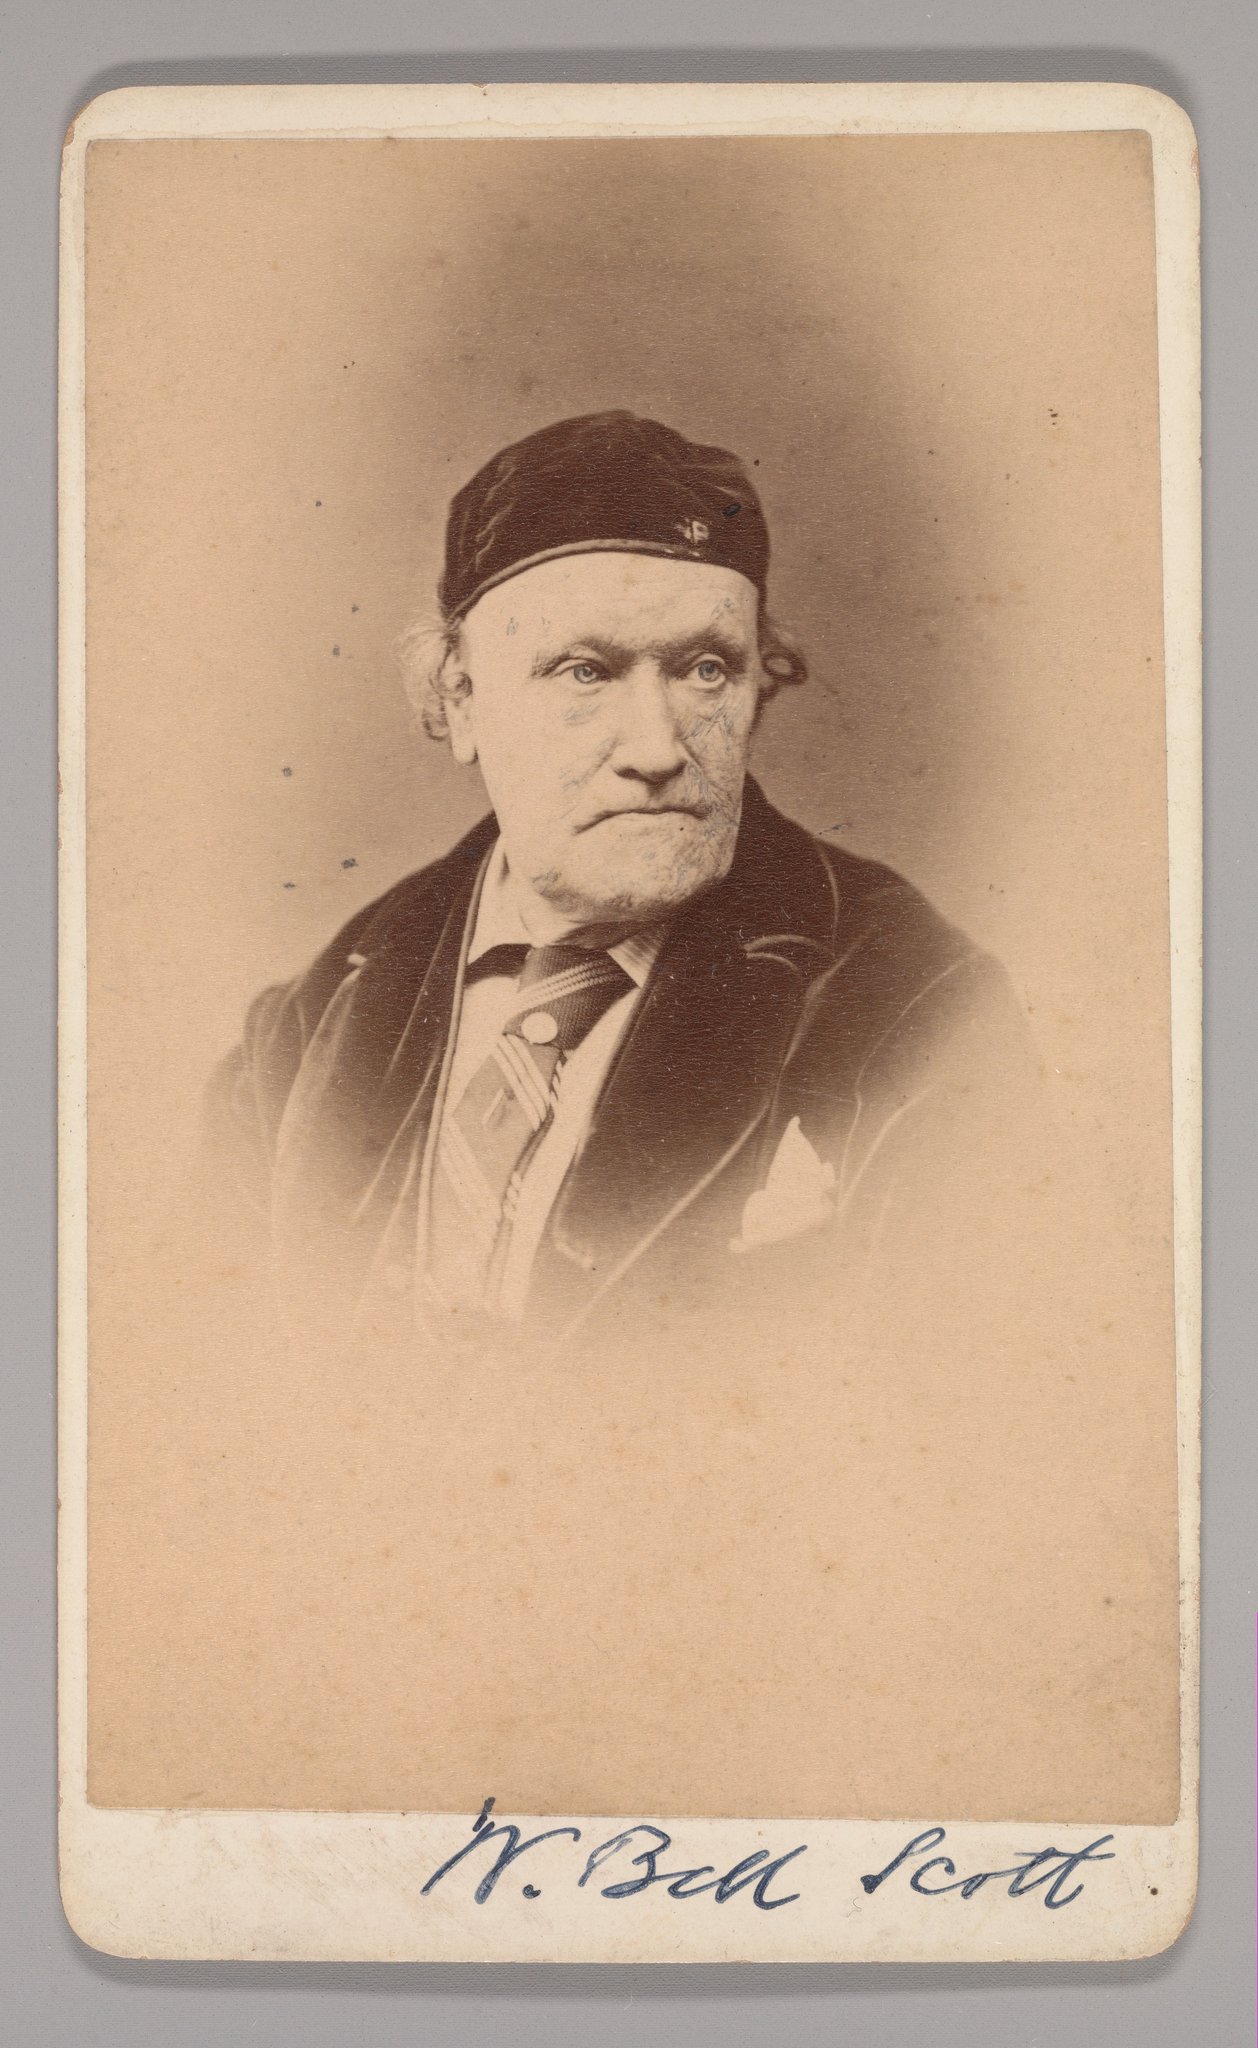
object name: carte de visite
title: [William Bell Scott]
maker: Anonymous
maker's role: artist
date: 1860-1869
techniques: albumen silver print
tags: men,portraits,artists